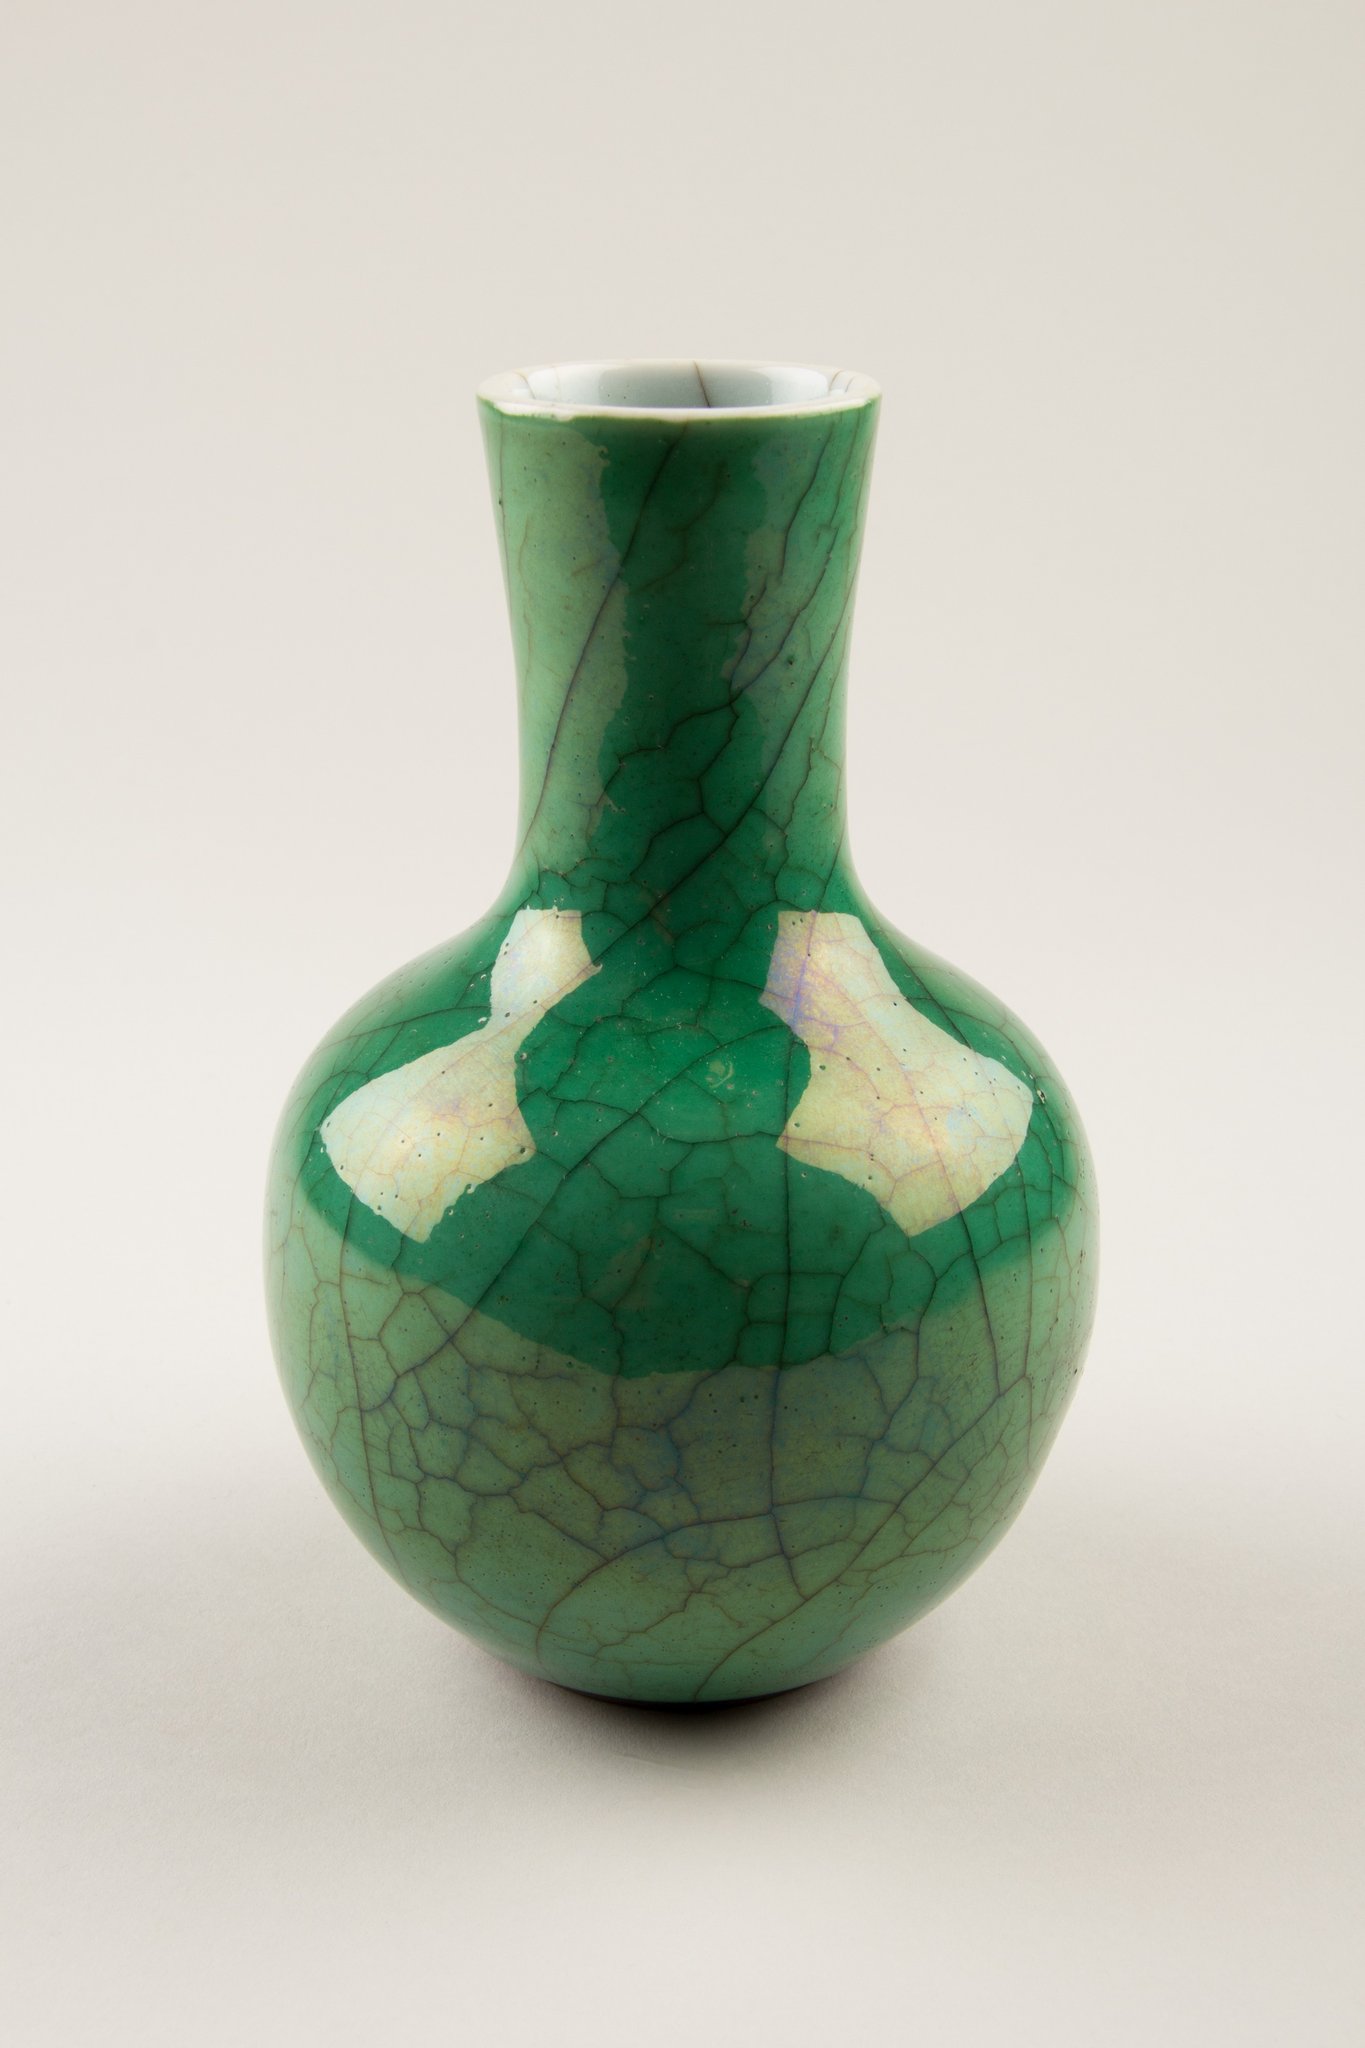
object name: vase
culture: chinese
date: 1662-1722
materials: porcelain